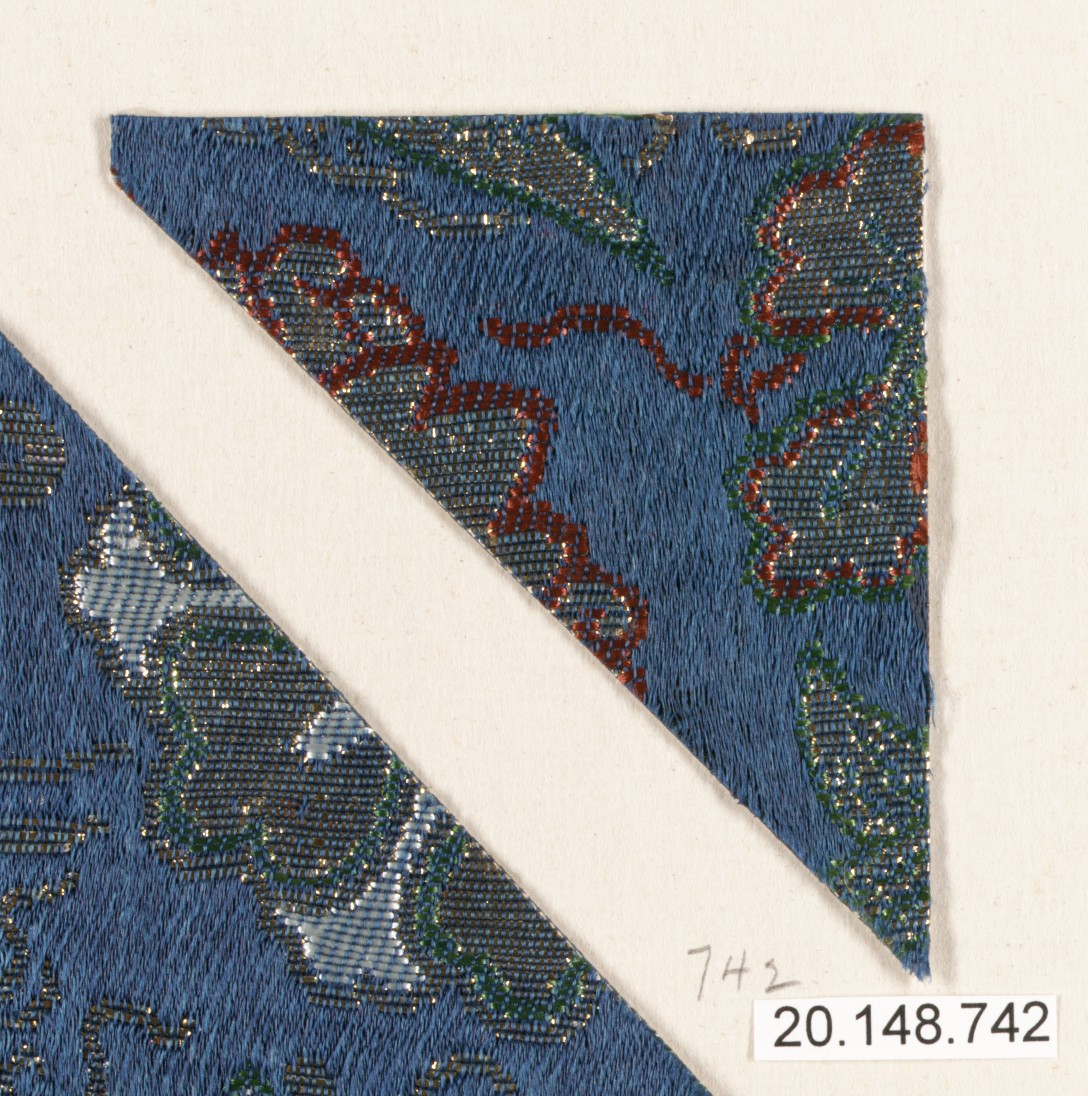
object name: piece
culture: japanese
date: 1601-1700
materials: silk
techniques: compound weave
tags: flowers